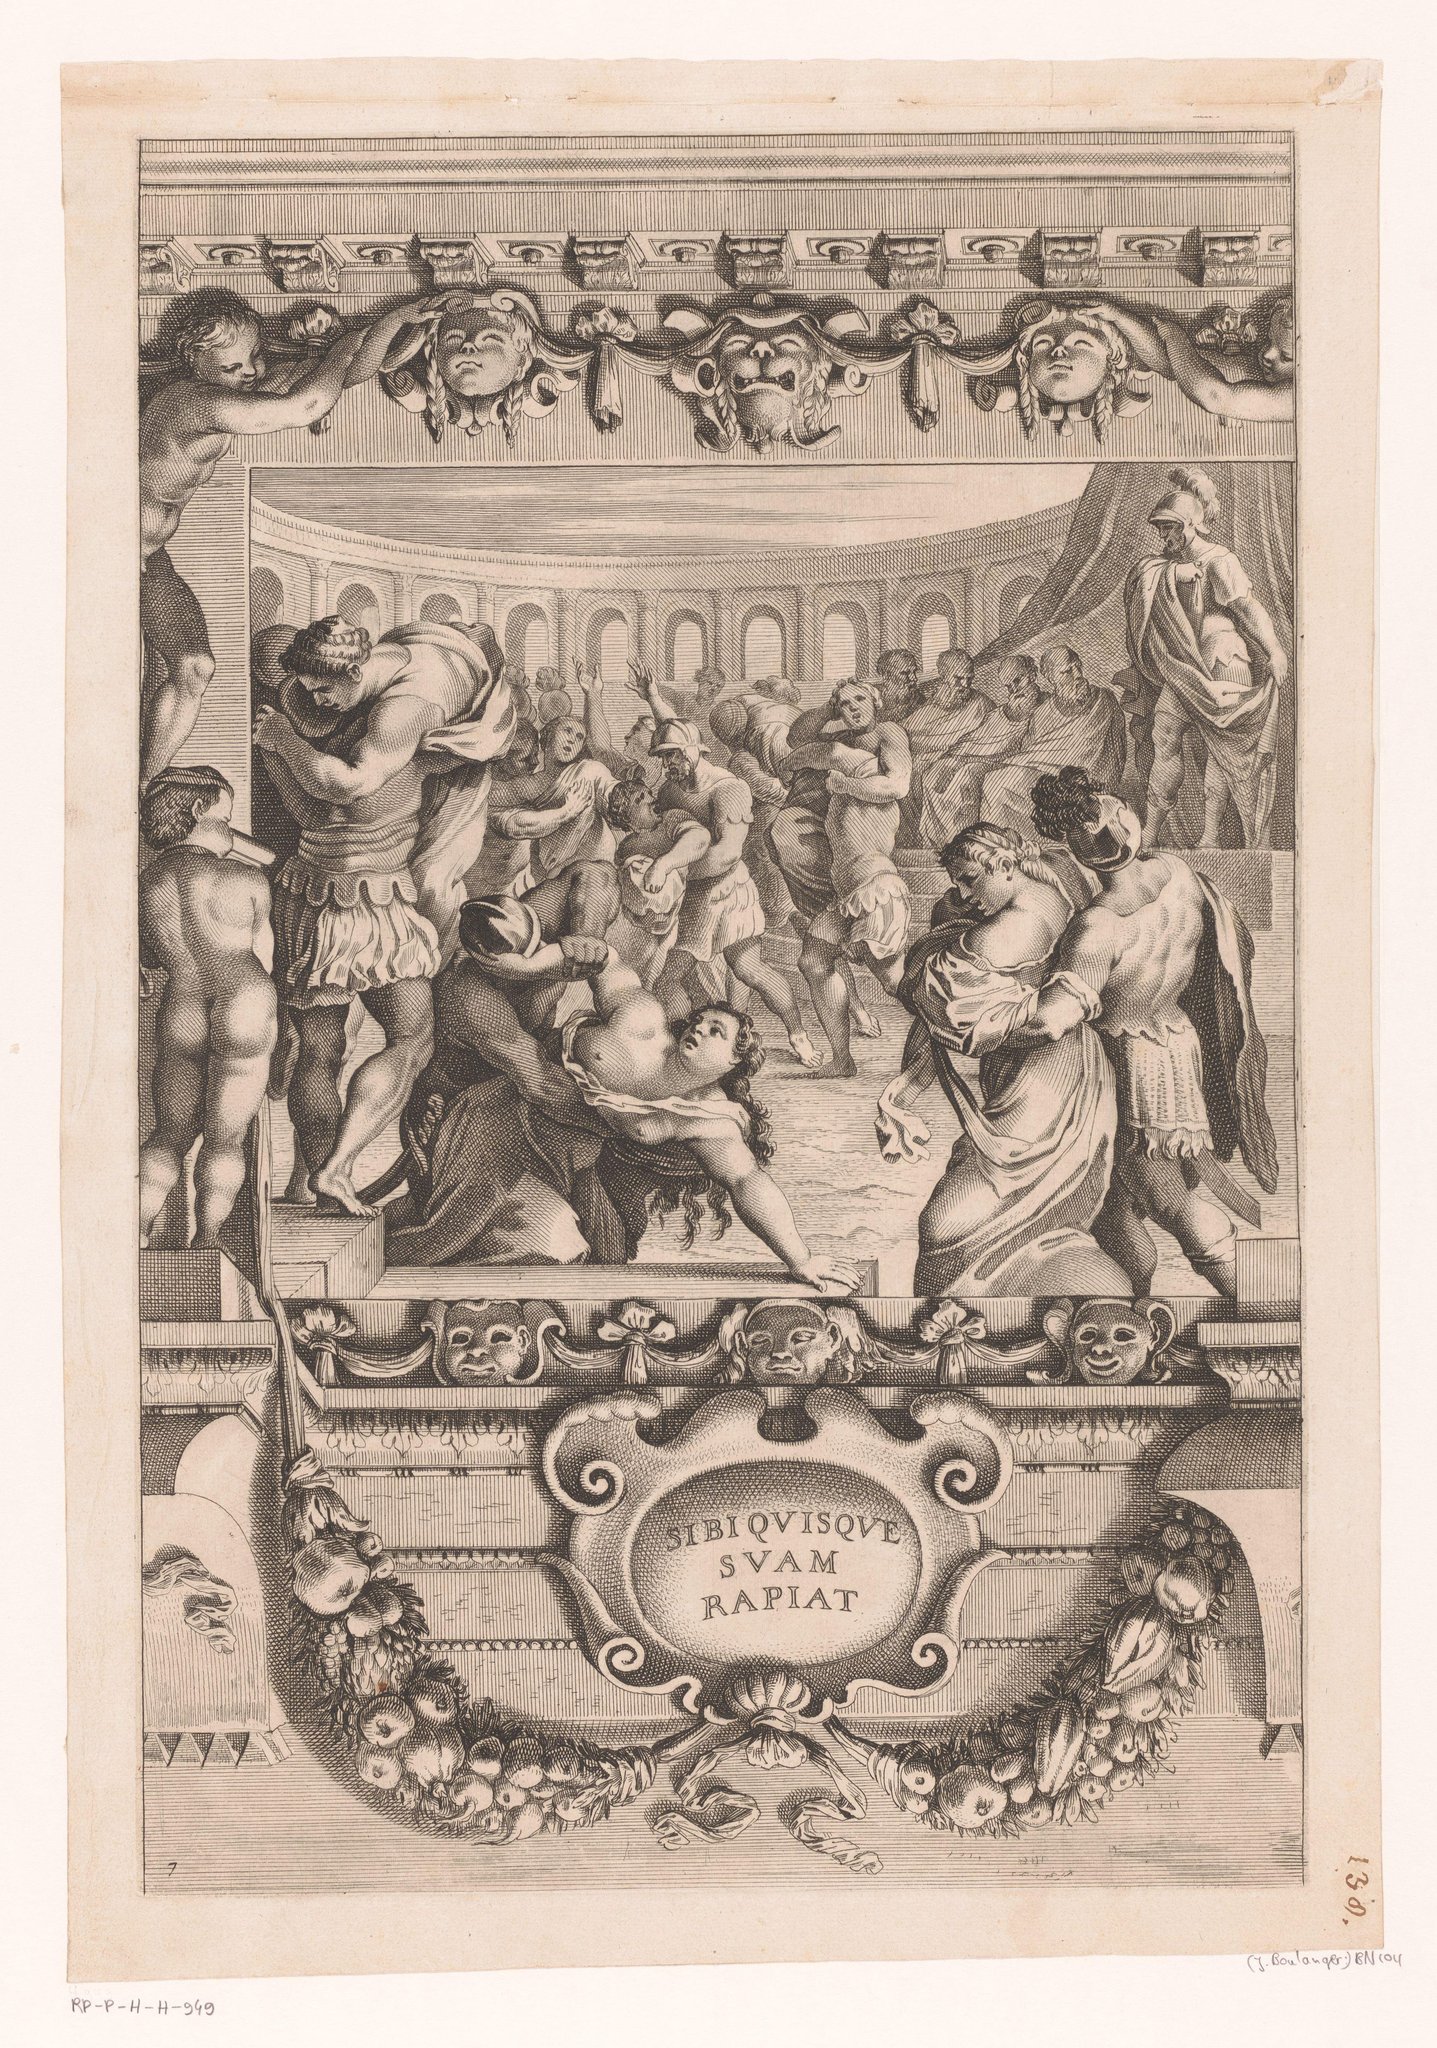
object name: print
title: Verhaal van Romulus en Remus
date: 1659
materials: paper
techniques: engraving, etching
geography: bologna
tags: rape of the sabine women: they are carried off by romulus and his men during a feast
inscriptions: number: ‘139.’, collector's mark: Lugt 11, number: ‘138.’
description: Maakt deel uit van een 14-delige serie met scènes uit het verhaal van Romulus en Remus naar ontwerpen door de familie Carracci voor het Palazzo Magnani te Bologna. Prent 1 t/m 7 zijn in prent gebracht door Lepautre en Boulanger en prent 8 t/m 14 door De Châtillon.